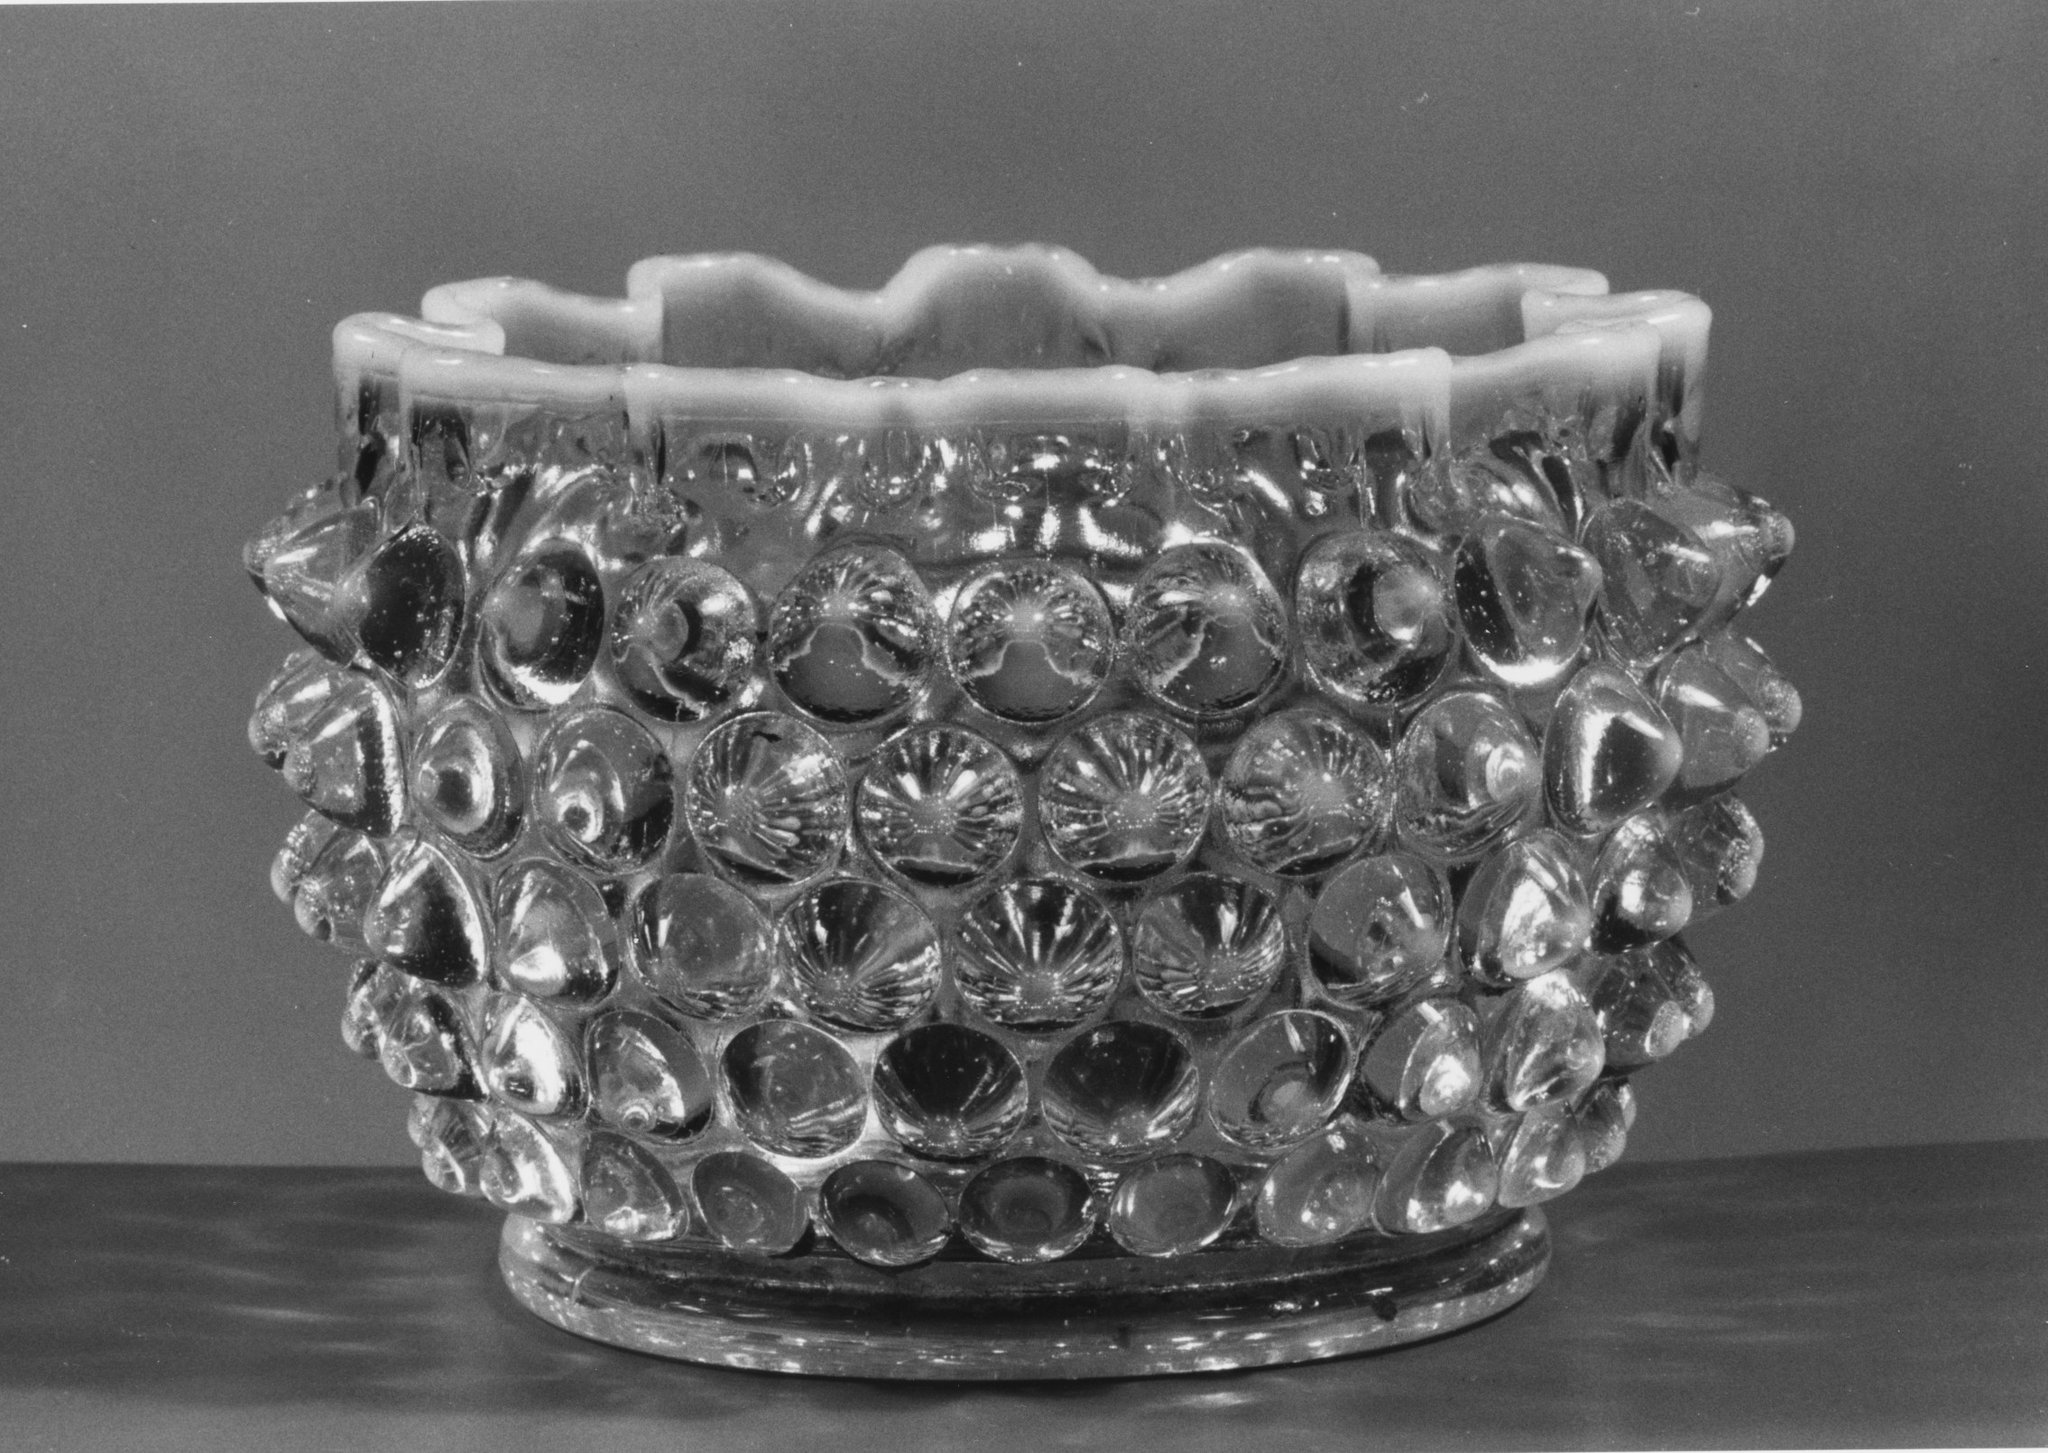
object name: finger bowl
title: Hobnail finger bowl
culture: american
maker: hobbs, brockunier and company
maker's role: maker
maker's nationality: american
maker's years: 1863-1891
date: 1890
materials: glass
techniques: pressed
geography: united states